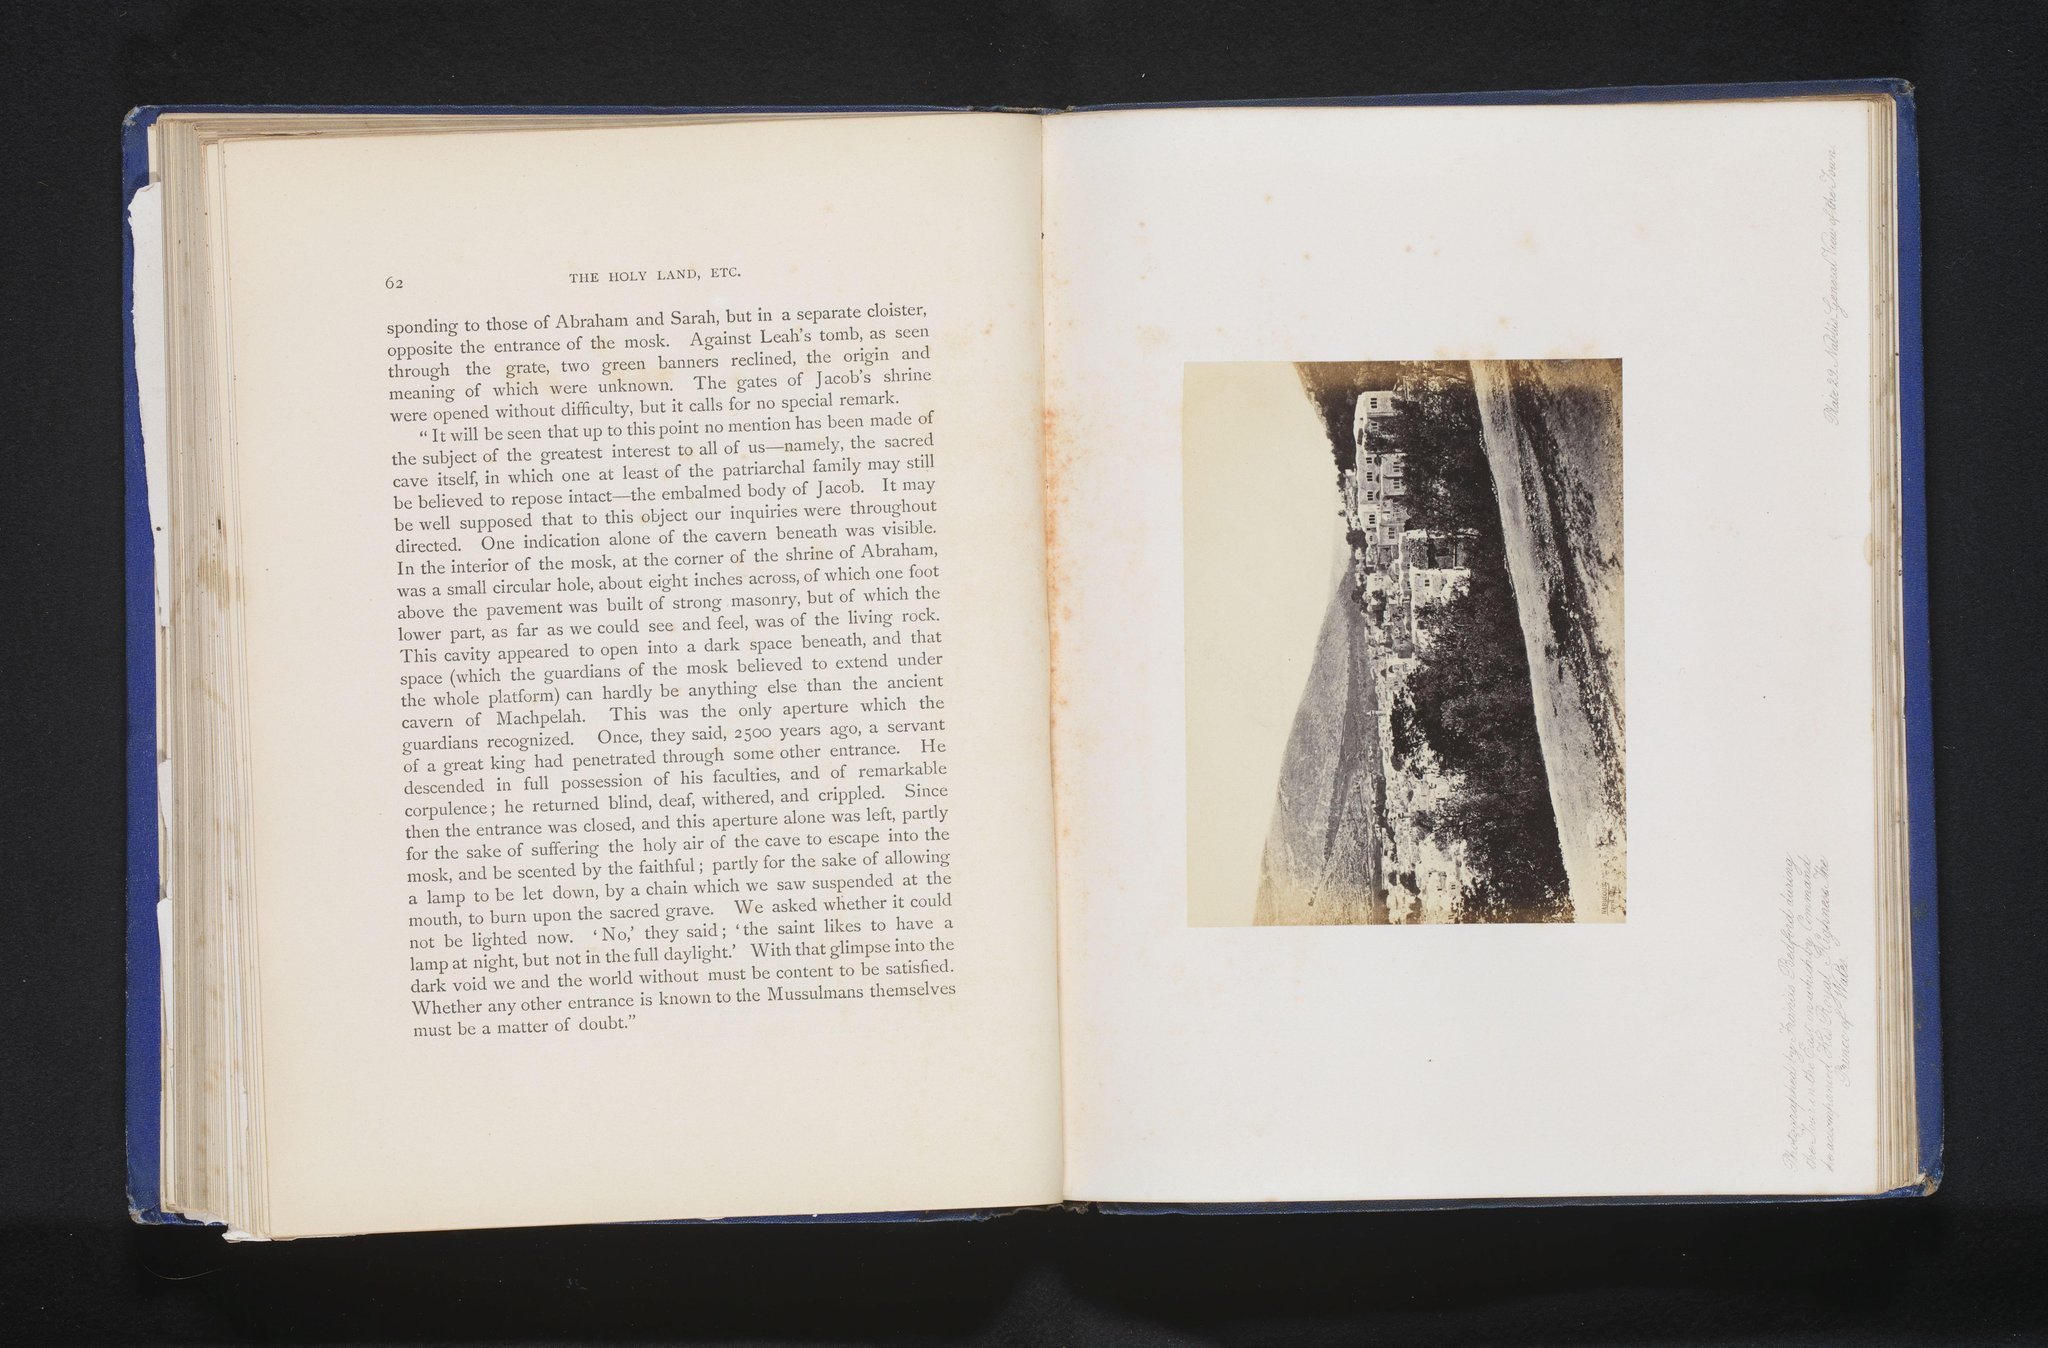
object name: page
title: Nablûs-General view of the town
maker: francis bedford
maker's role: print maker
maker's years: 1815-1894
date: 1861-1866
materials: photographic support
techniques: albumen print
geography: palestine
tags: city-view in general; 'veduta'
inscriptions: number: ‘Plate 29.’, inscription: ‘Photographed by Francis Bedford during the Tour in the East on which by Command he accompanied His Royal Highness The Prince of Wales’